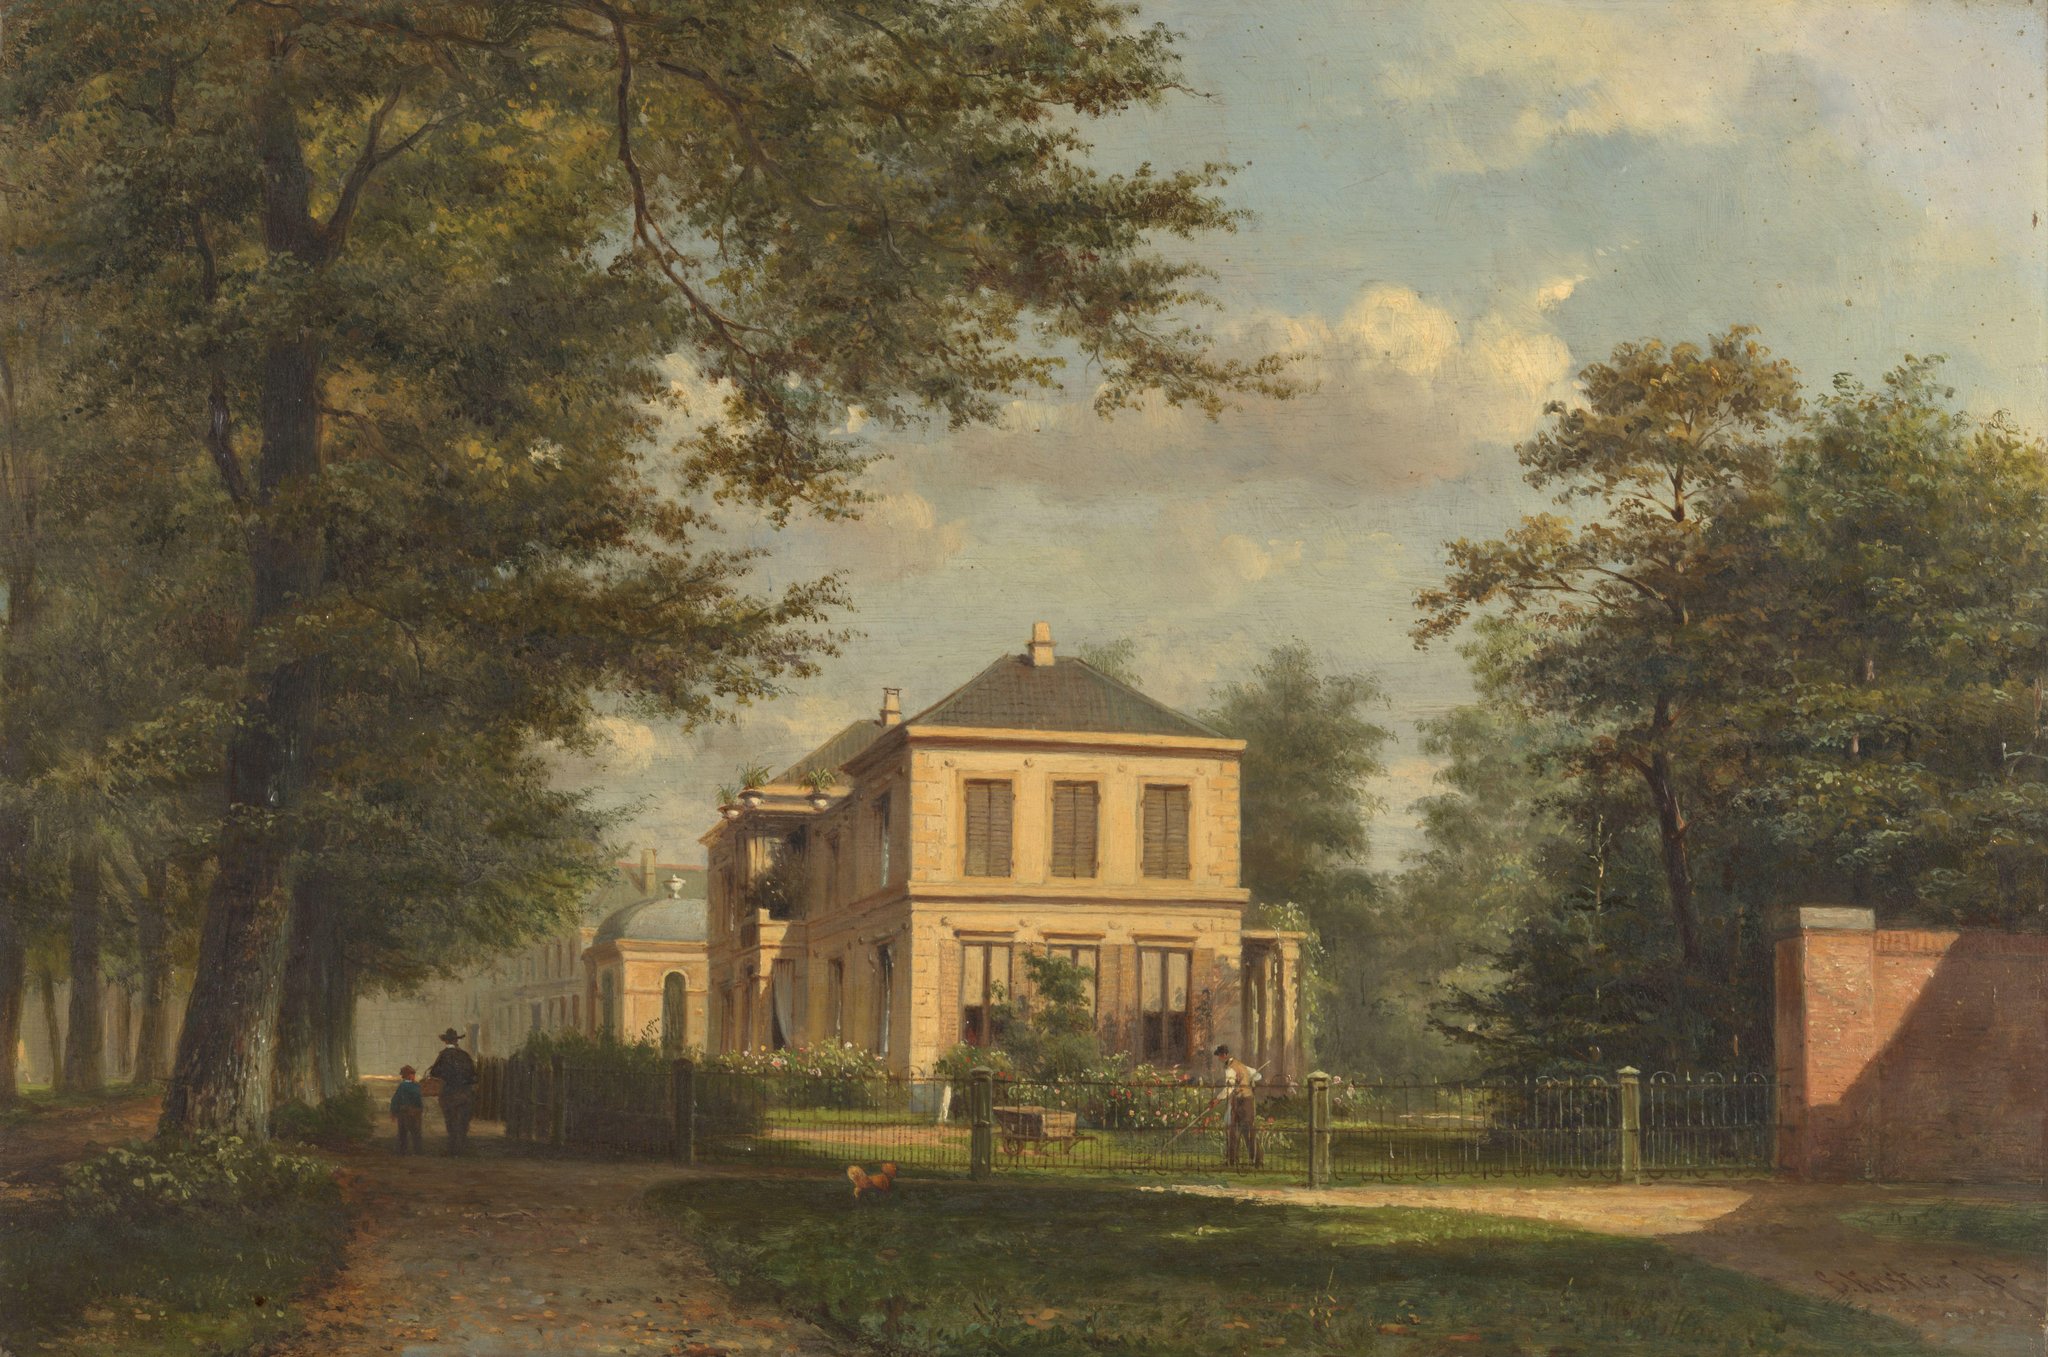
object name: painting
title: Het buiten Zorg Vrij aan de Kleine Houtweg te Haarlem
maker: everhardus koster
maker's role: draughtsman, painter, print maker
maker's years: 1817-1892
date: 1883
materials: oil, panel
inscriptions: label: ‘1883’